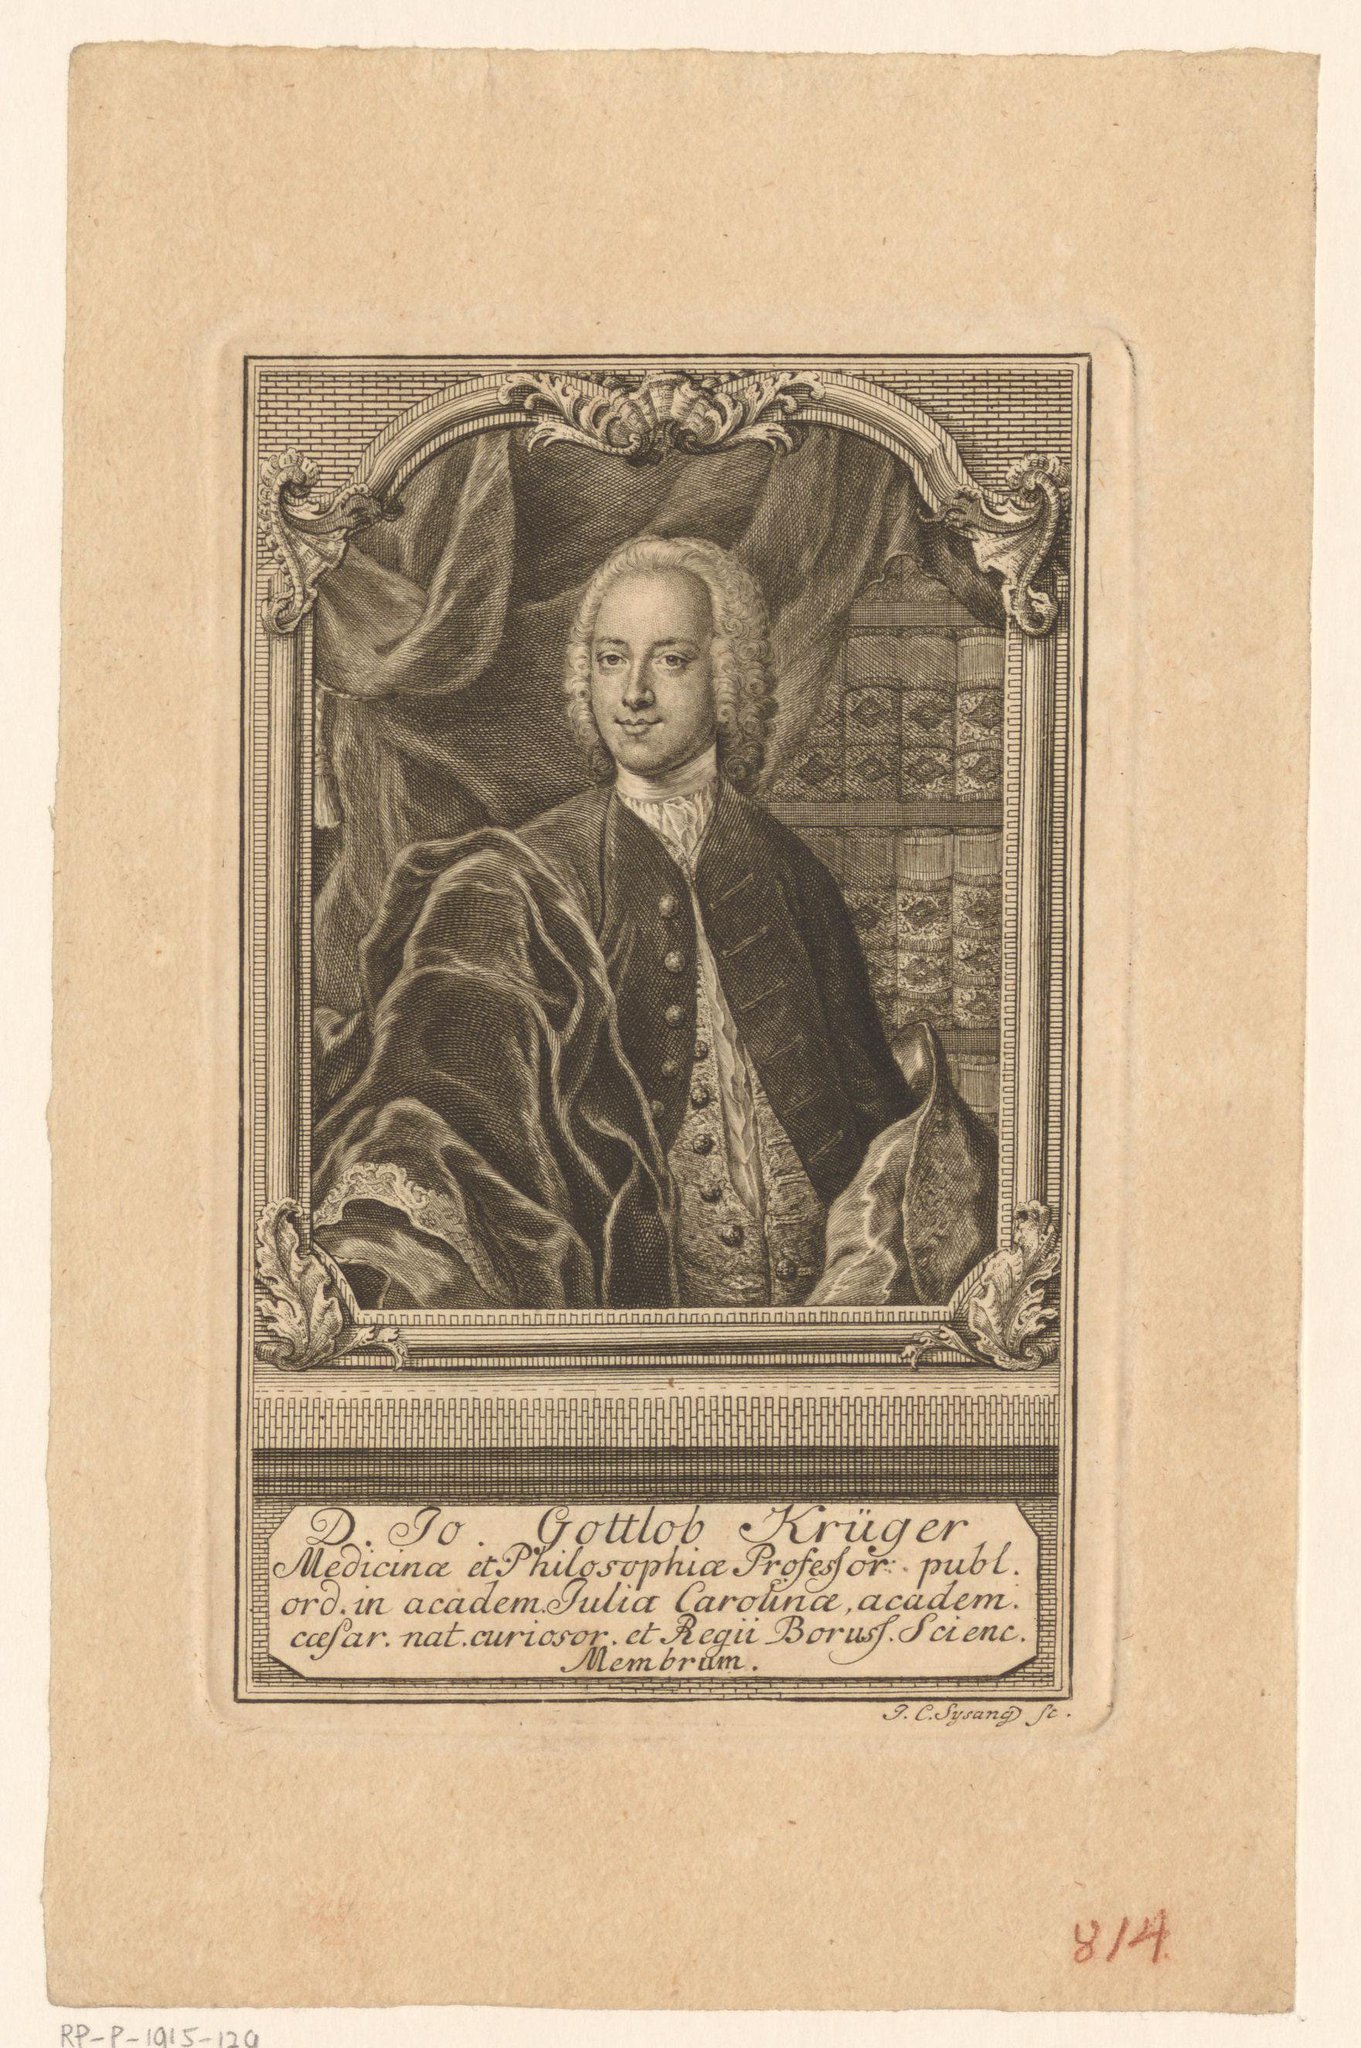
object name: print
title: Portret van Johann Gottlob Krüger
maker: johann christoph sysang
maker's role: print maker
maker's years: 1703-1757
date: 1768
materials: paper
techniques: engraving, etching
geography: leipzig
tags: bookshelves, historical persons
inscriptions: collector's mark: Lugt 2233, number: ‘814’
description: Prent gebruikt voor de publicatie: Krüger, Johann Gottlob. Die ersten Gründe der Naturlehre. Halle an der Saale en Helmstedt: Carl Hermann Hemmerde, 1768.